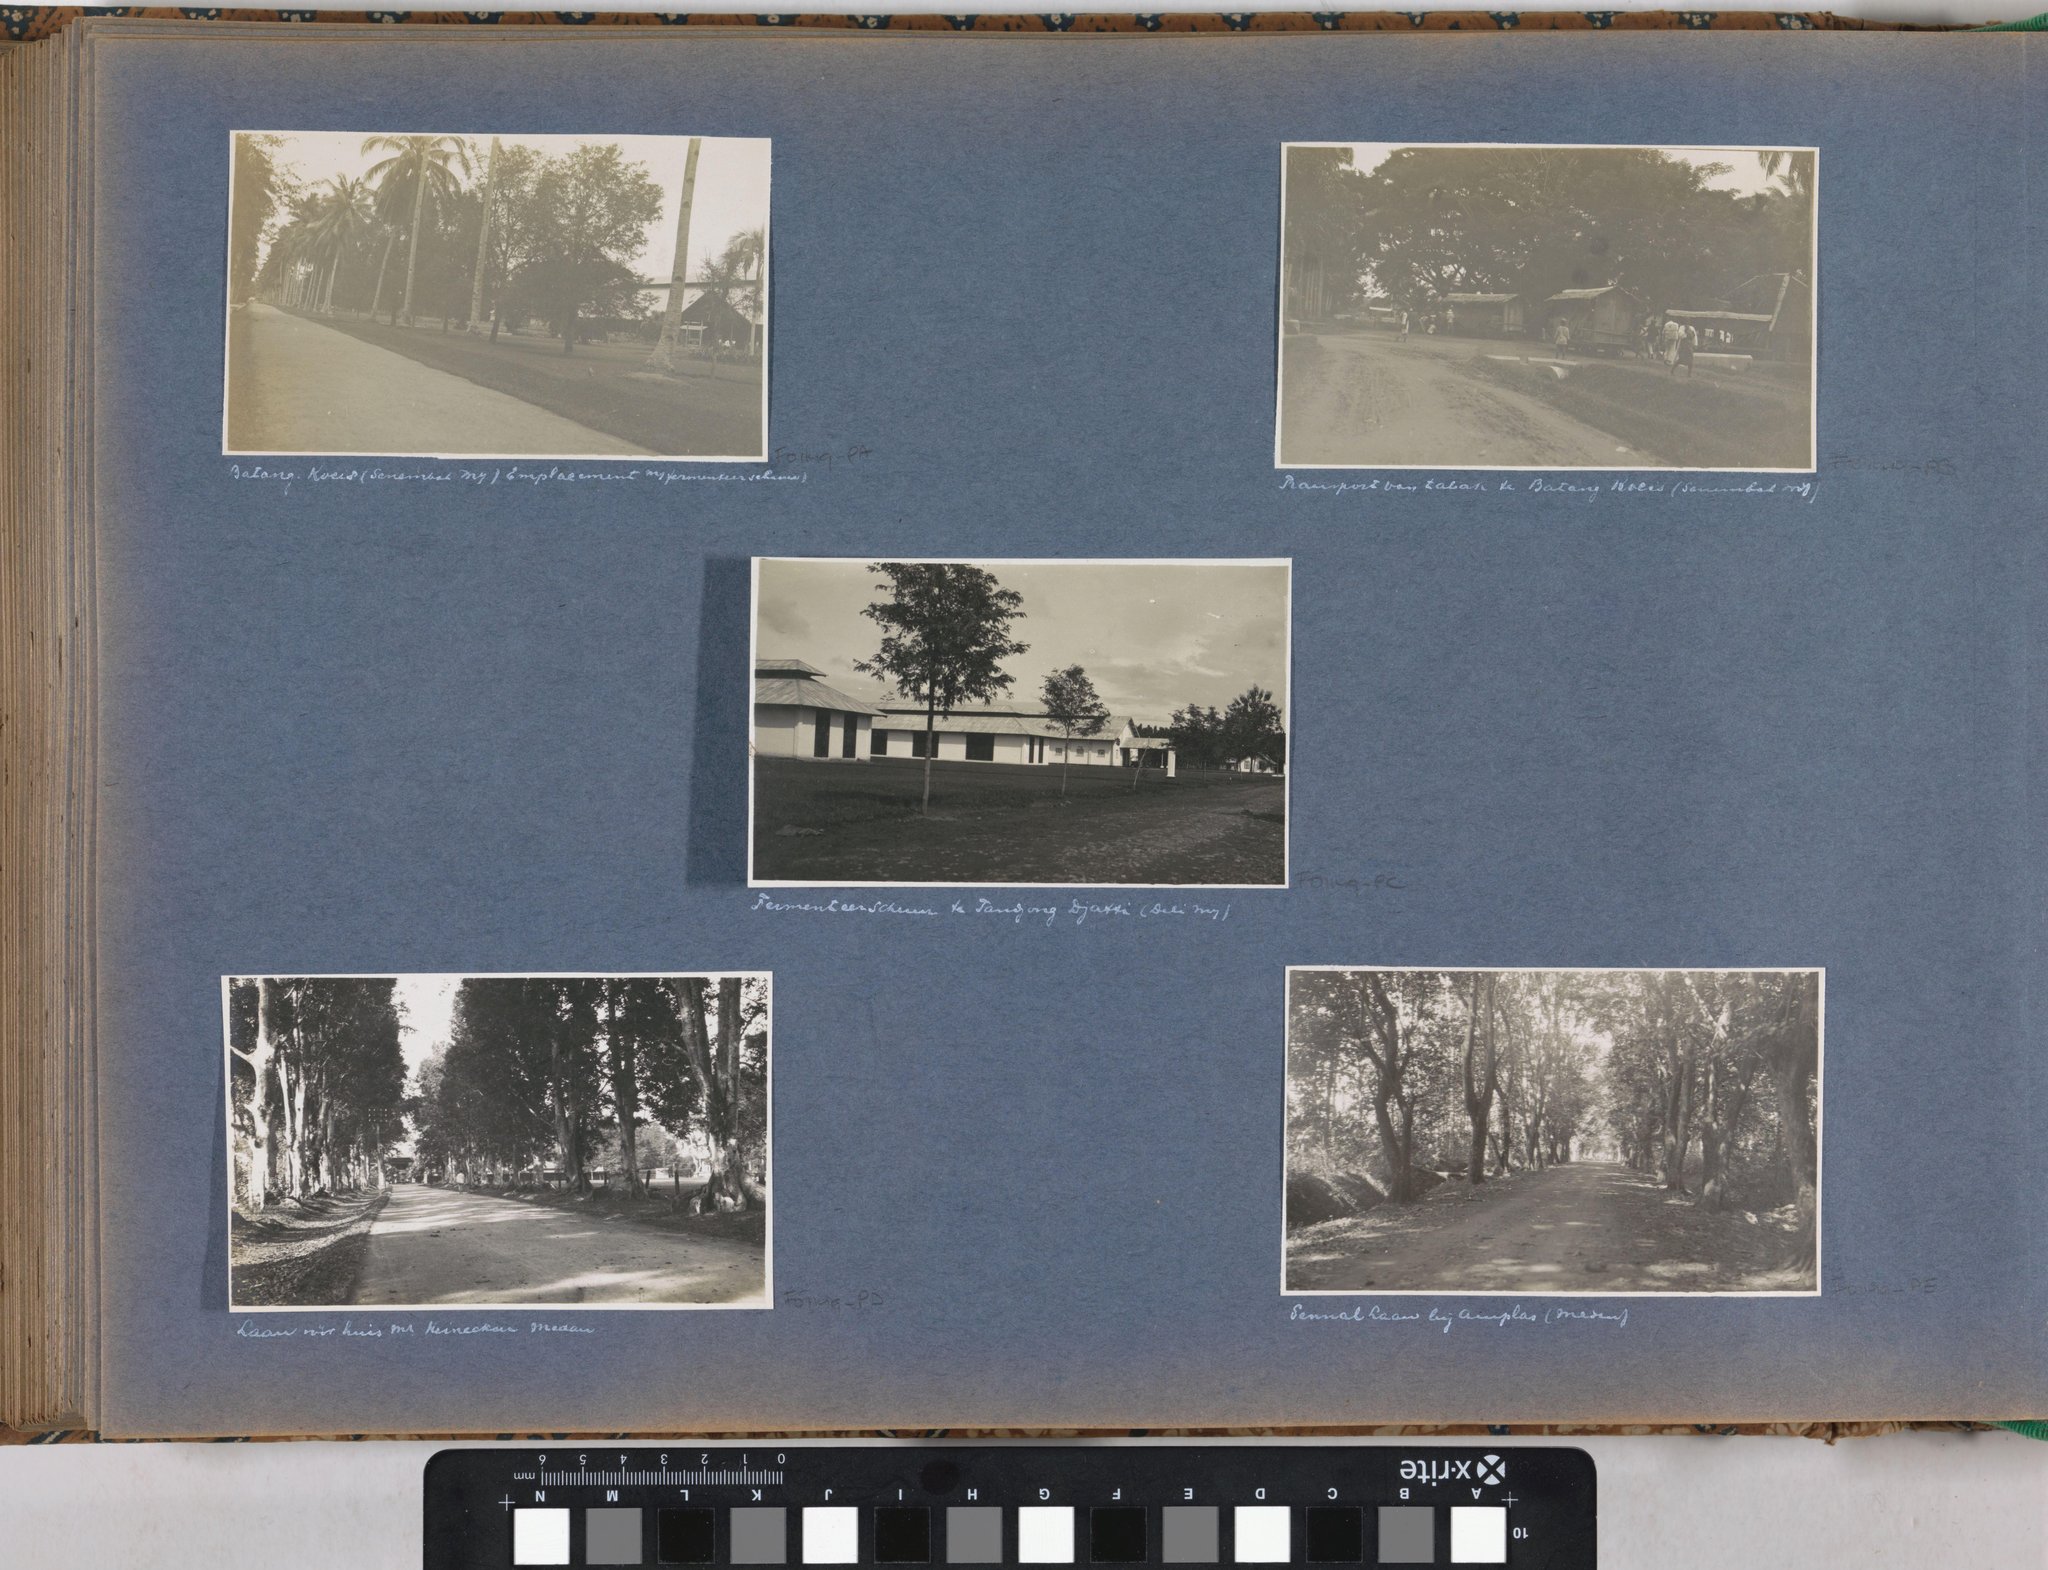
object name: album leaf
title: Exterieur van fermenteerschuren van de Deli Maatschappij te Pandjang Djati op Sumatra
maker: Anonymous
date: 1900-1920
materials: paper, photographic support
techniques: gelatin silver print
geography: sumatra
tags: plantation, barn, sumatra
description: Onderdeel van reisalbum met foto's van bedrijvigheid en bezienswaardigheden op Sumatra en Java en van de reis naar en van Nederlands-Indië.